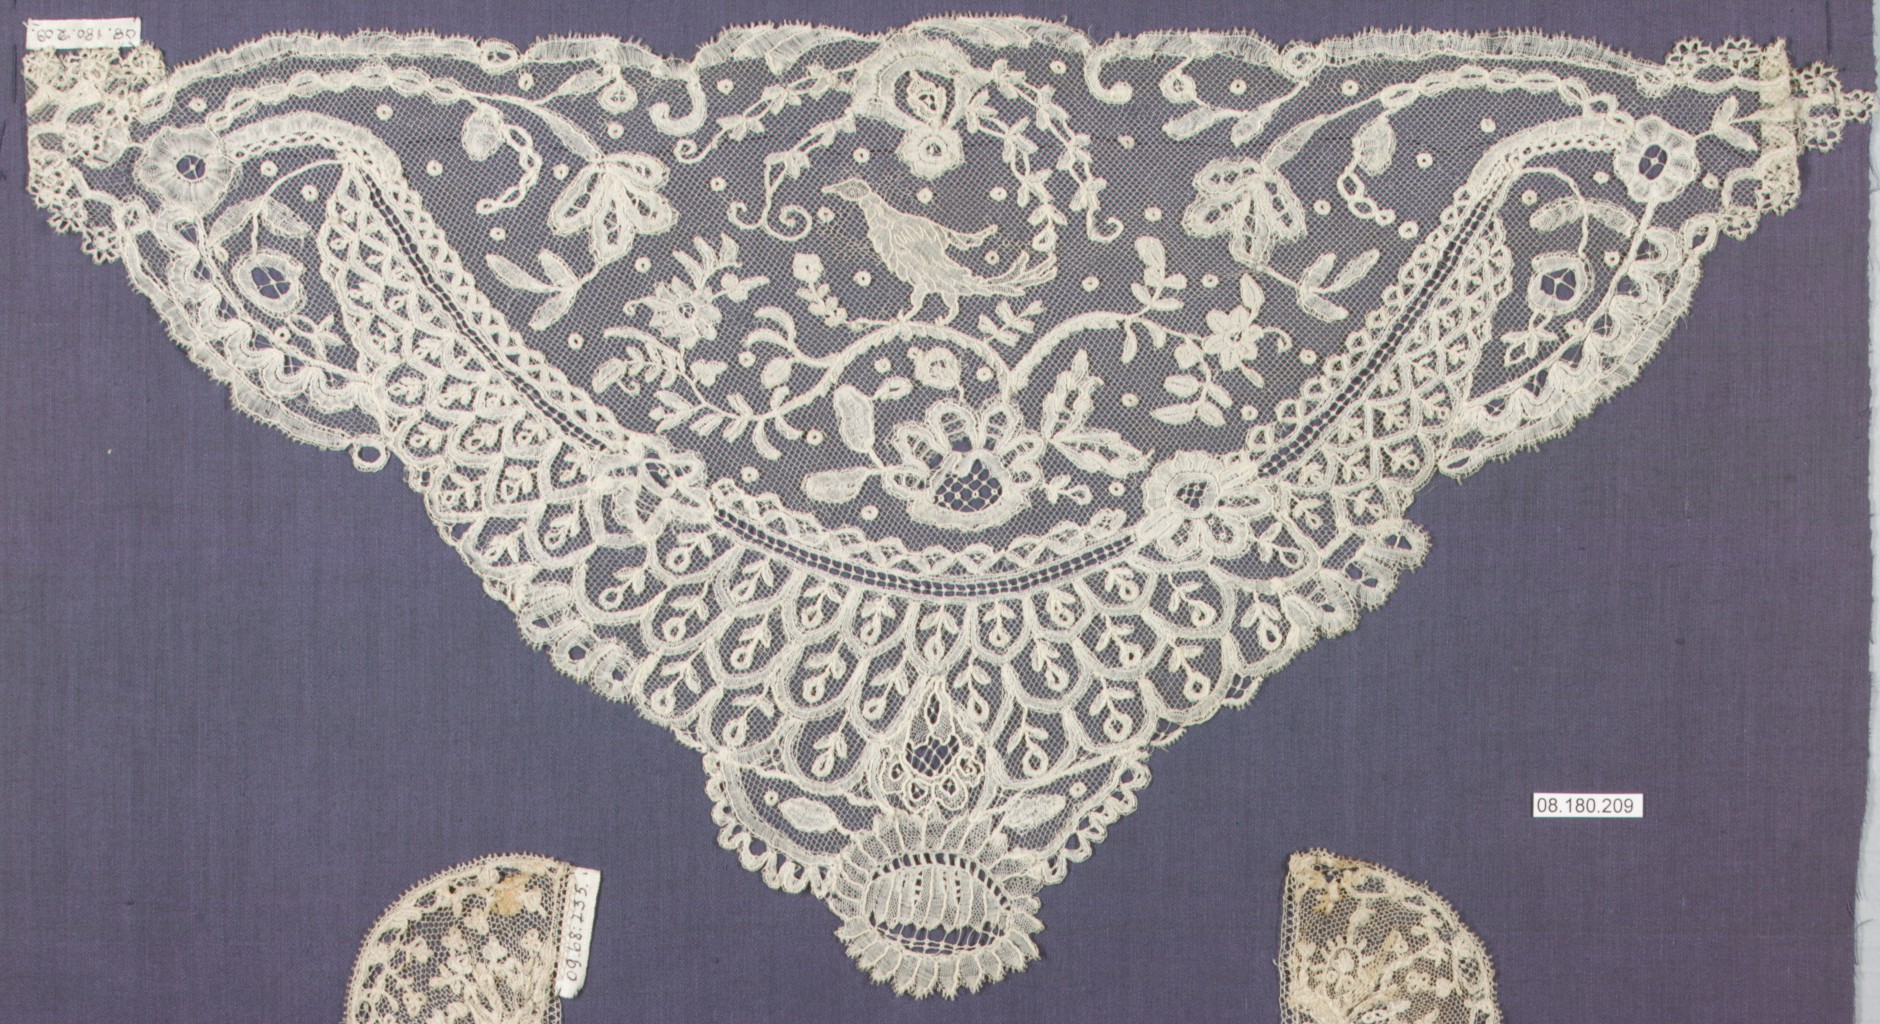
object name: fragment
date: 1801-1900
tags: birds,flowers,leaves